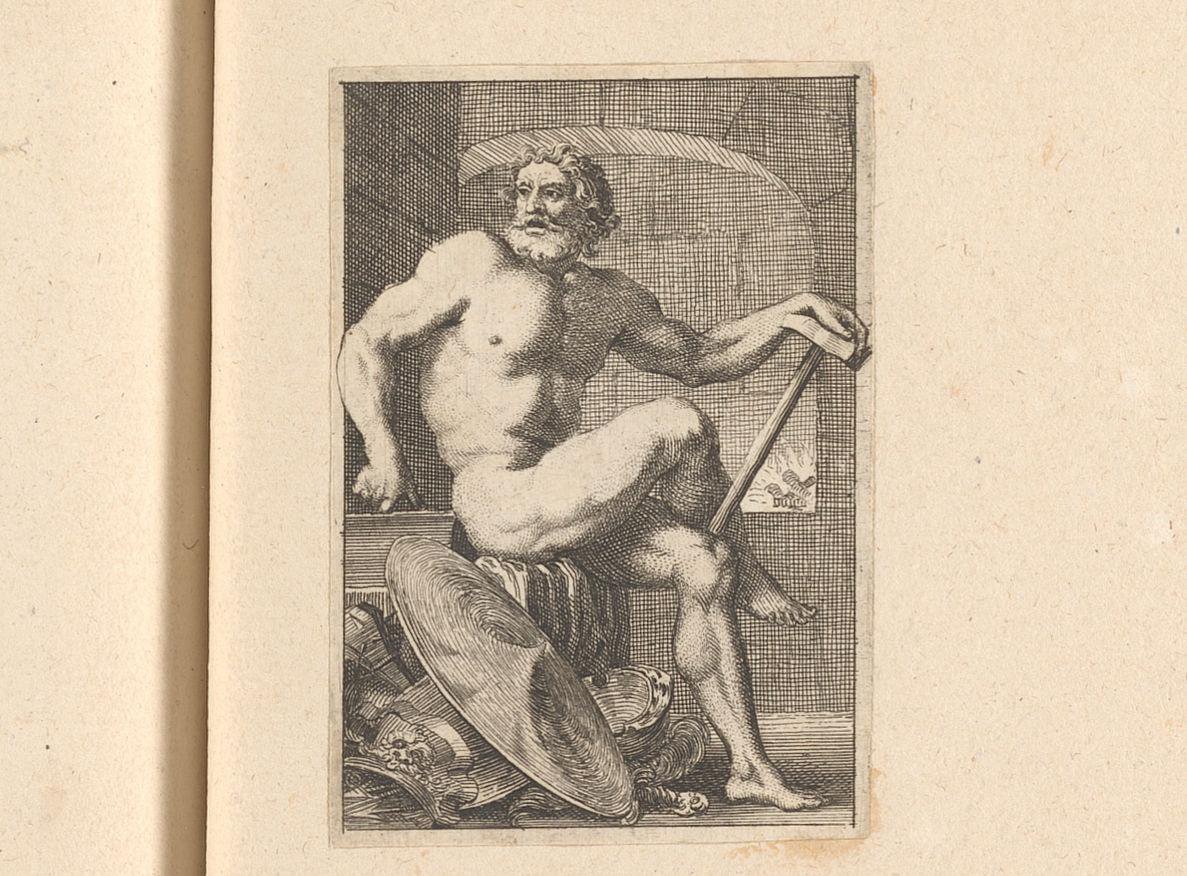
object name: album leaf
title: Vulcanus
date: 1665-1673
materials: paper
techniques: etching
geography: paris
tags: (story of) vulcan (hephaestus), model-books ~ implements of painter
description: Maakt deel uit van een 32-delige serie met tekenvoorbeelden van goden en helden uit de klassieke oudheid. Een eerste editie werd in 1673 uitgegeven en een tweede in 1684 door Nicolas Langlois.